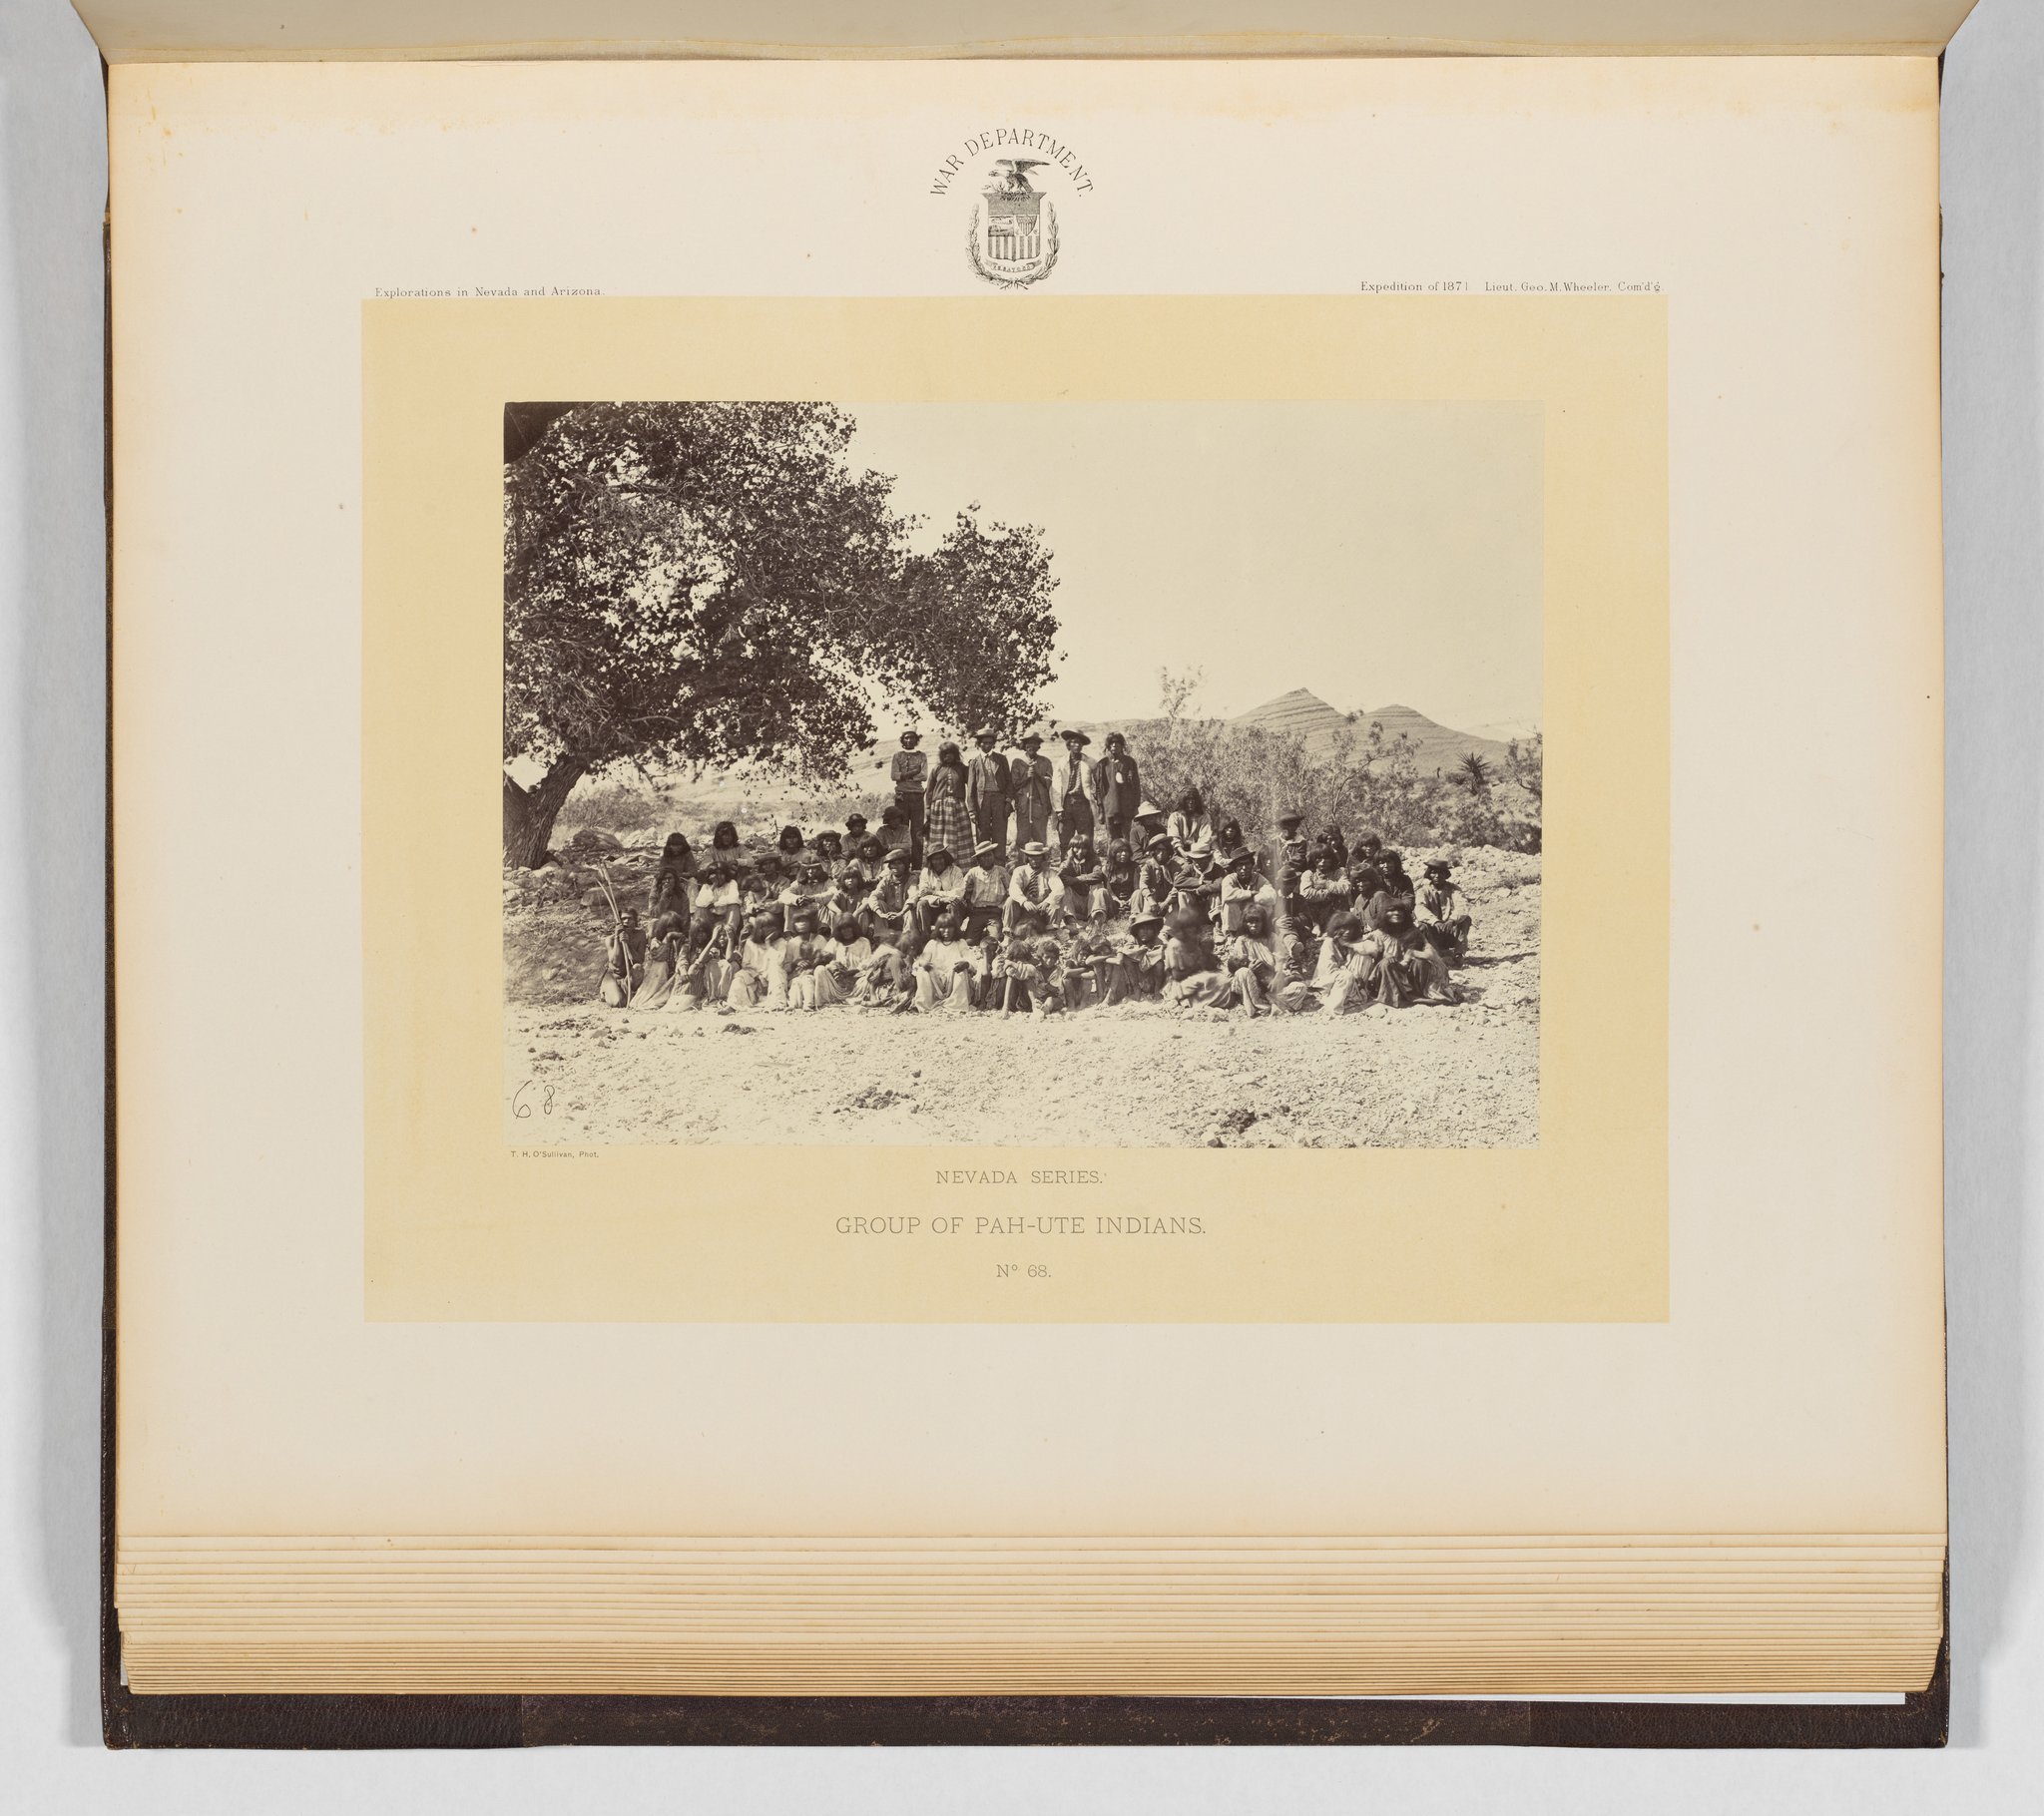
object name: photograph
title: Group of Pah-Ute Indians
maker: timothy h. o'sullivan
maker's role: artist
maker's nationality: american, born ireland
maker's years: 1840-1882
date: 1871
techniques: albumen silver print, glass negative